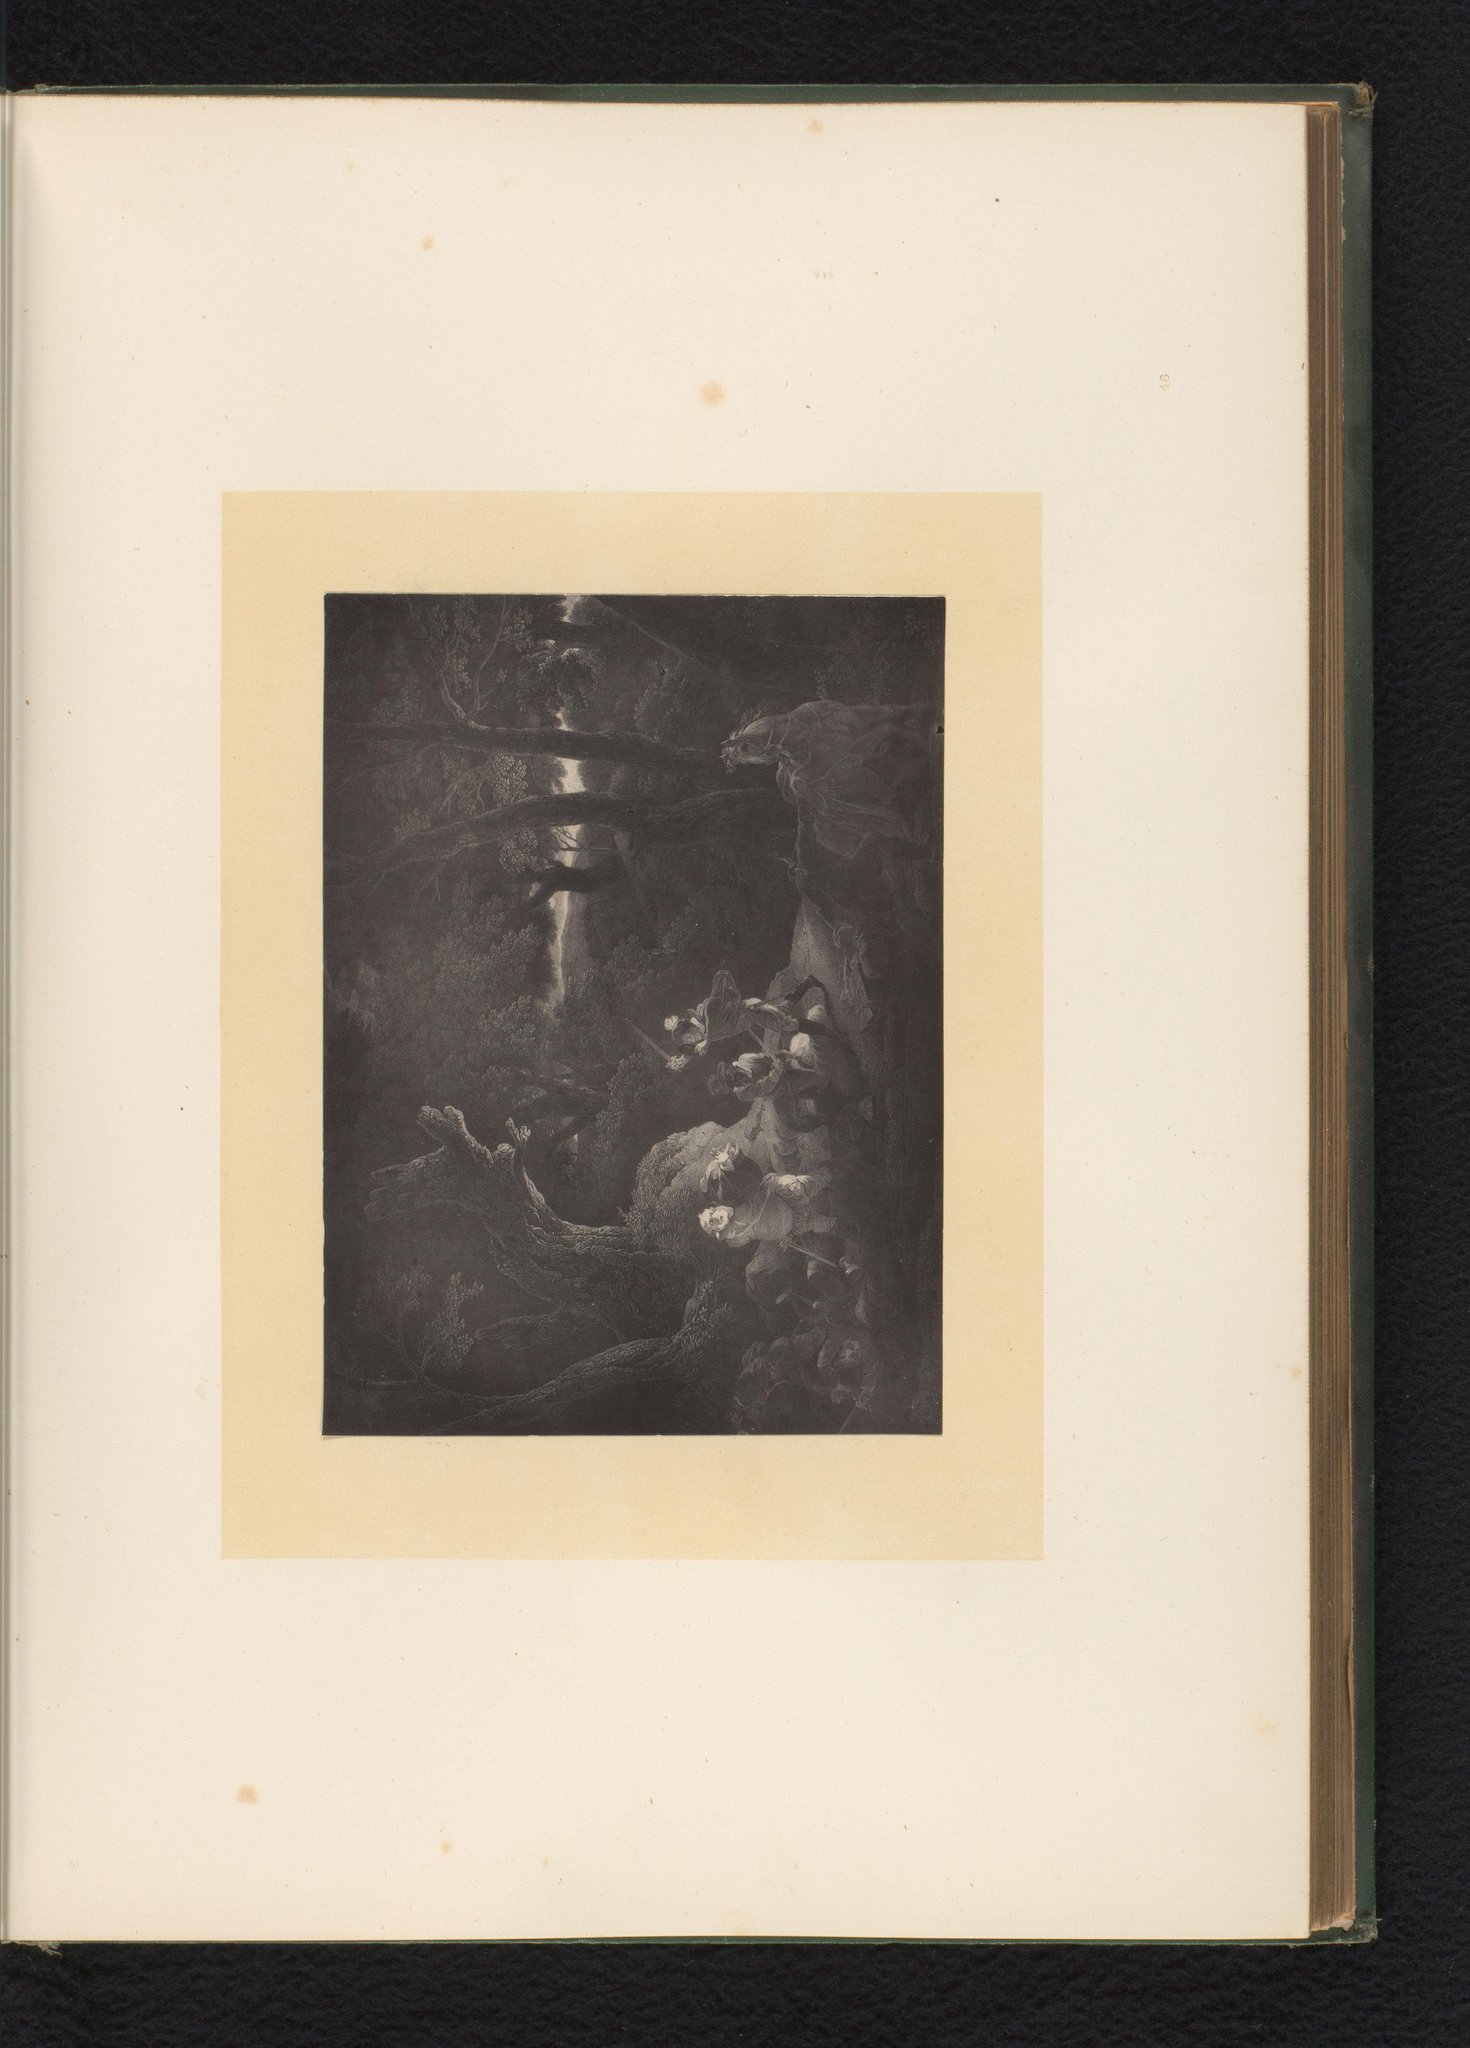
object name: page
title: King Henry the Fourth, Act II, Scene 2: The Road to Gadshill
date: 1874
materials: paper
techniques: woodburytype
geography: london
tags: theatre, theatrical performance